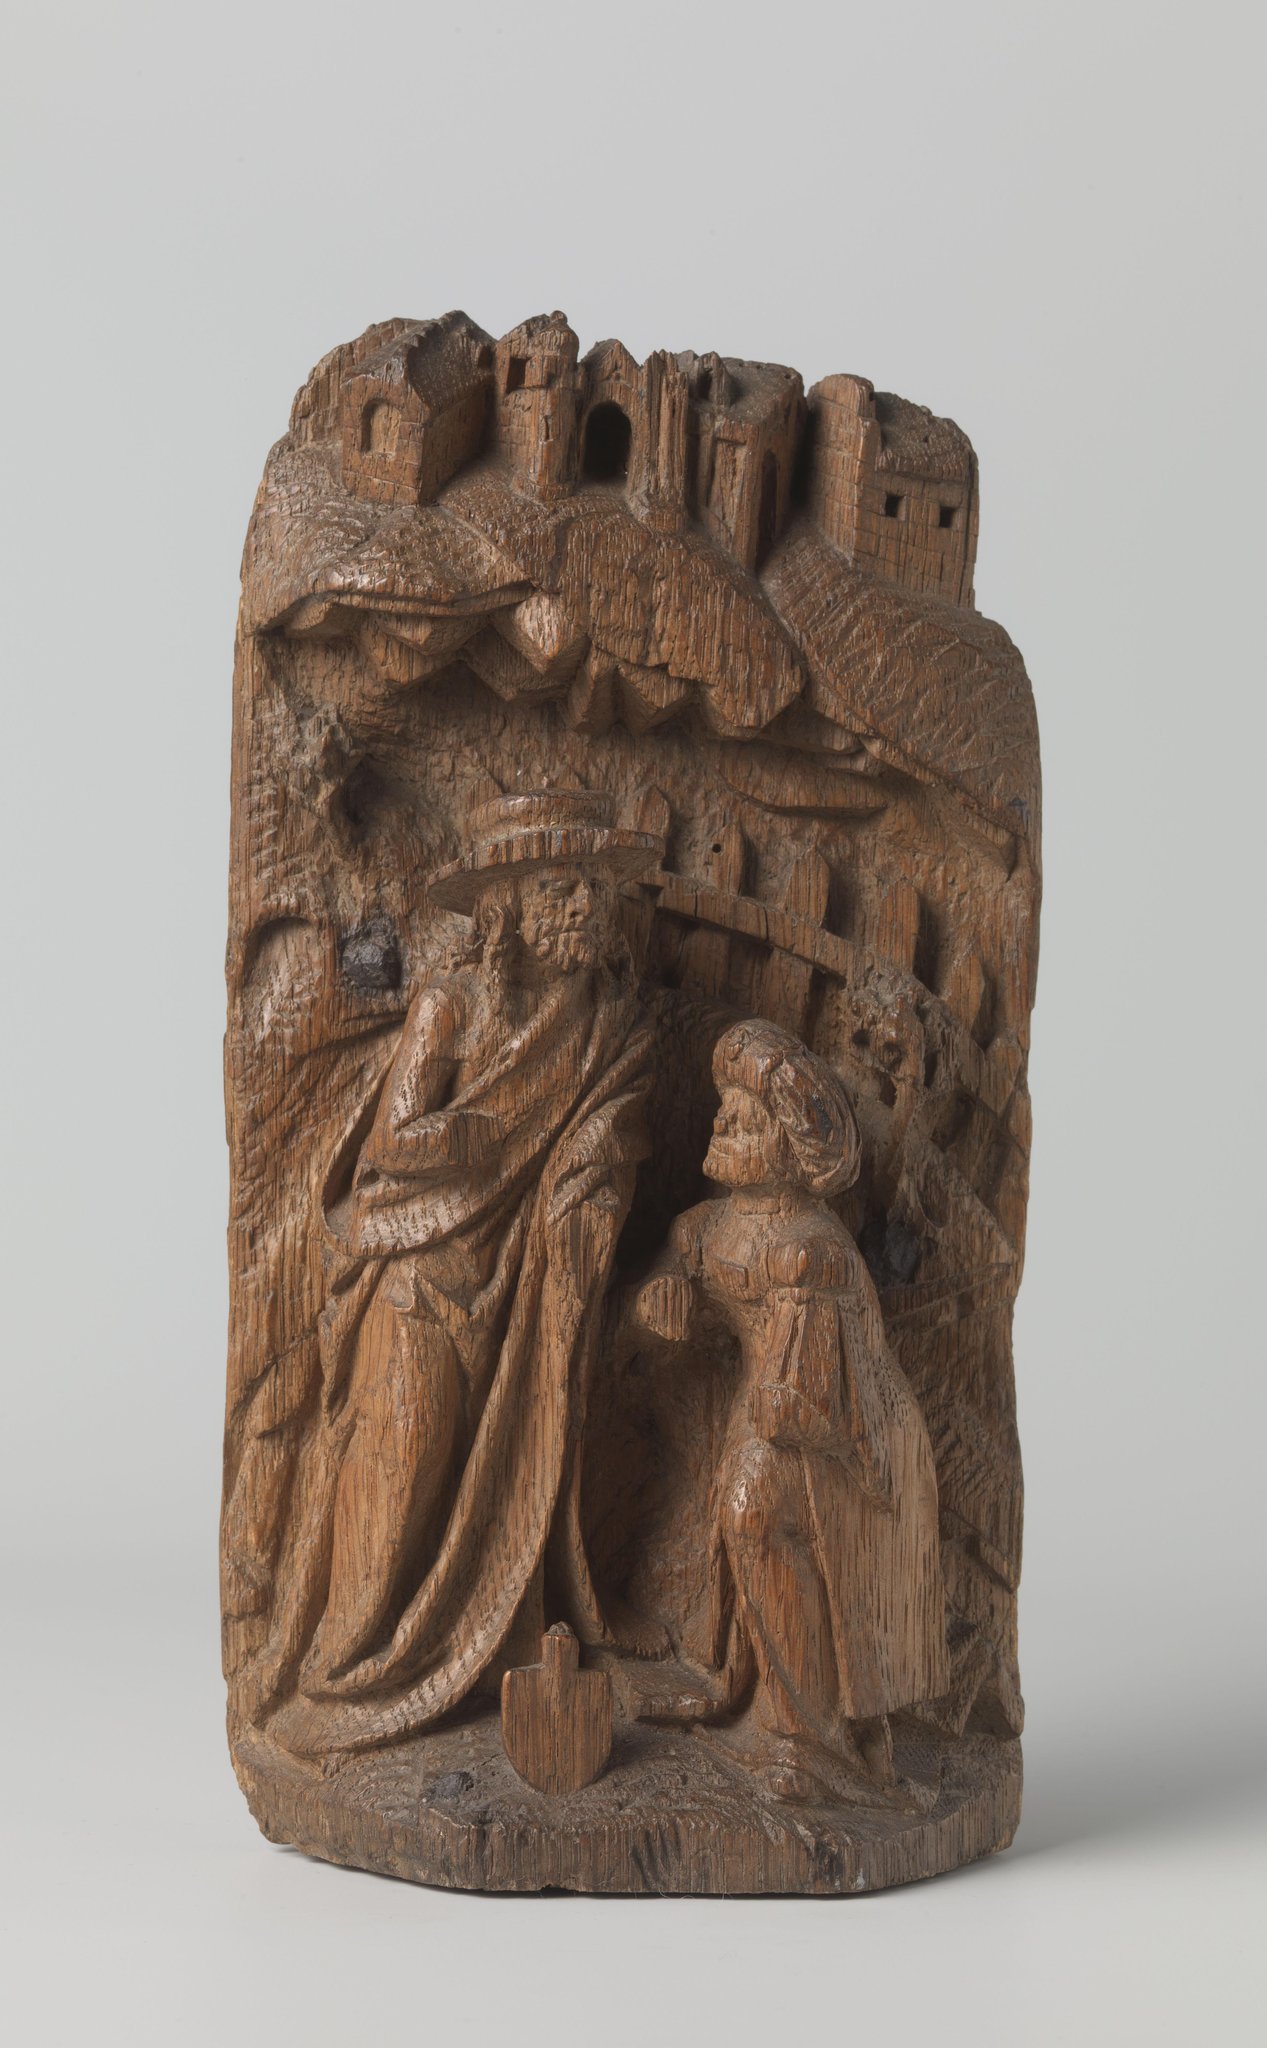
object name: sculpture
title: Christ Appearing to Mary Magdalene (Noli me Tangere)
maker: Anonymous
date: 1515-1520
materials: wood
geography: antwerp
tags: mary magdalene kneeling before christ, who is usually represented as a gardener with a hoe and/or a spade; 'noli me tangere'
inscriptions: mark, on the front side along the lower edge of the base, branded: a hand (the Antwerp wood quality mark)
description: Christ Appearing to Mary Magdalene. Oak, originally with polychromy. Antwerp, c. 1515 - 1520.